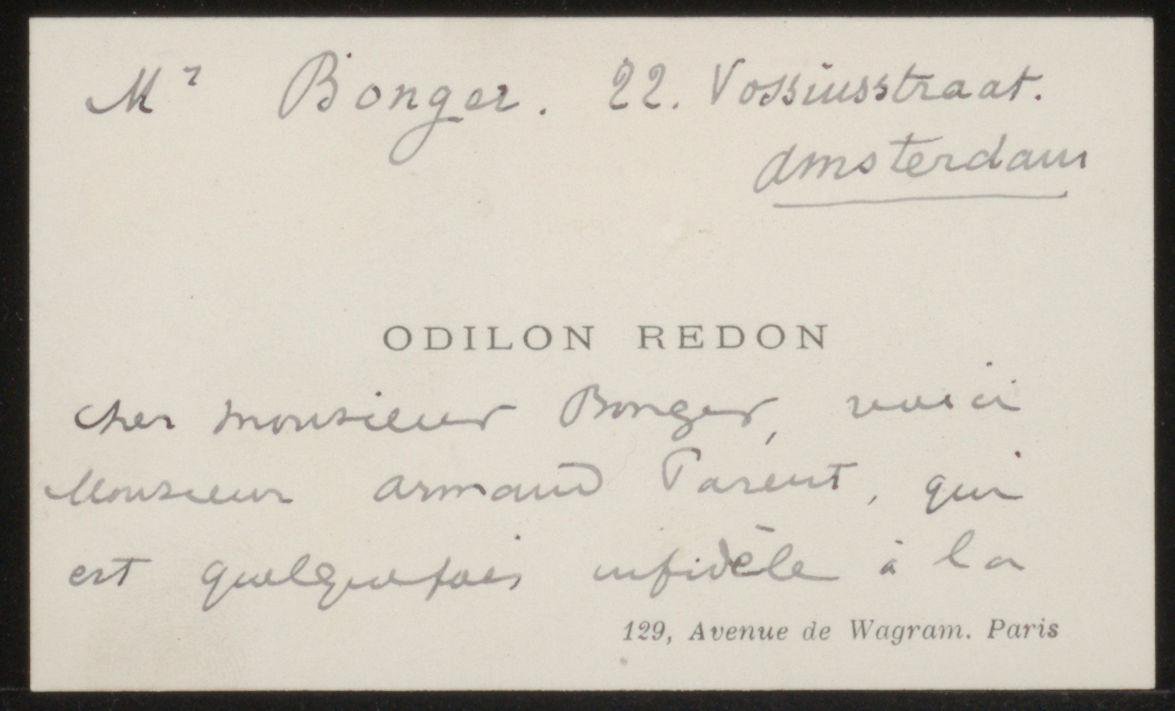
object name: visiting card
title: Visitekaartje aan Andries Bonger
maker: odilon redon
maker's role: draughtsman, painter, print maker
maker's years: 1840-1916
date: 1913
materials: cardboard, ink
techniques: pen, printing, writing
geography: paris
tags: liège, amsterdam, andries bonger, music, painting (including book-illumination, miniature-painting)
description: Visitekaartje behoort tot een album samengesteld door weduwe Françoise W.M. Barones van der Borch van Verwolde met afschriften van brieven met betrekking tot (de familie van) Odilon Redon. Het visitekaartje werd bewaard op pagina 197.